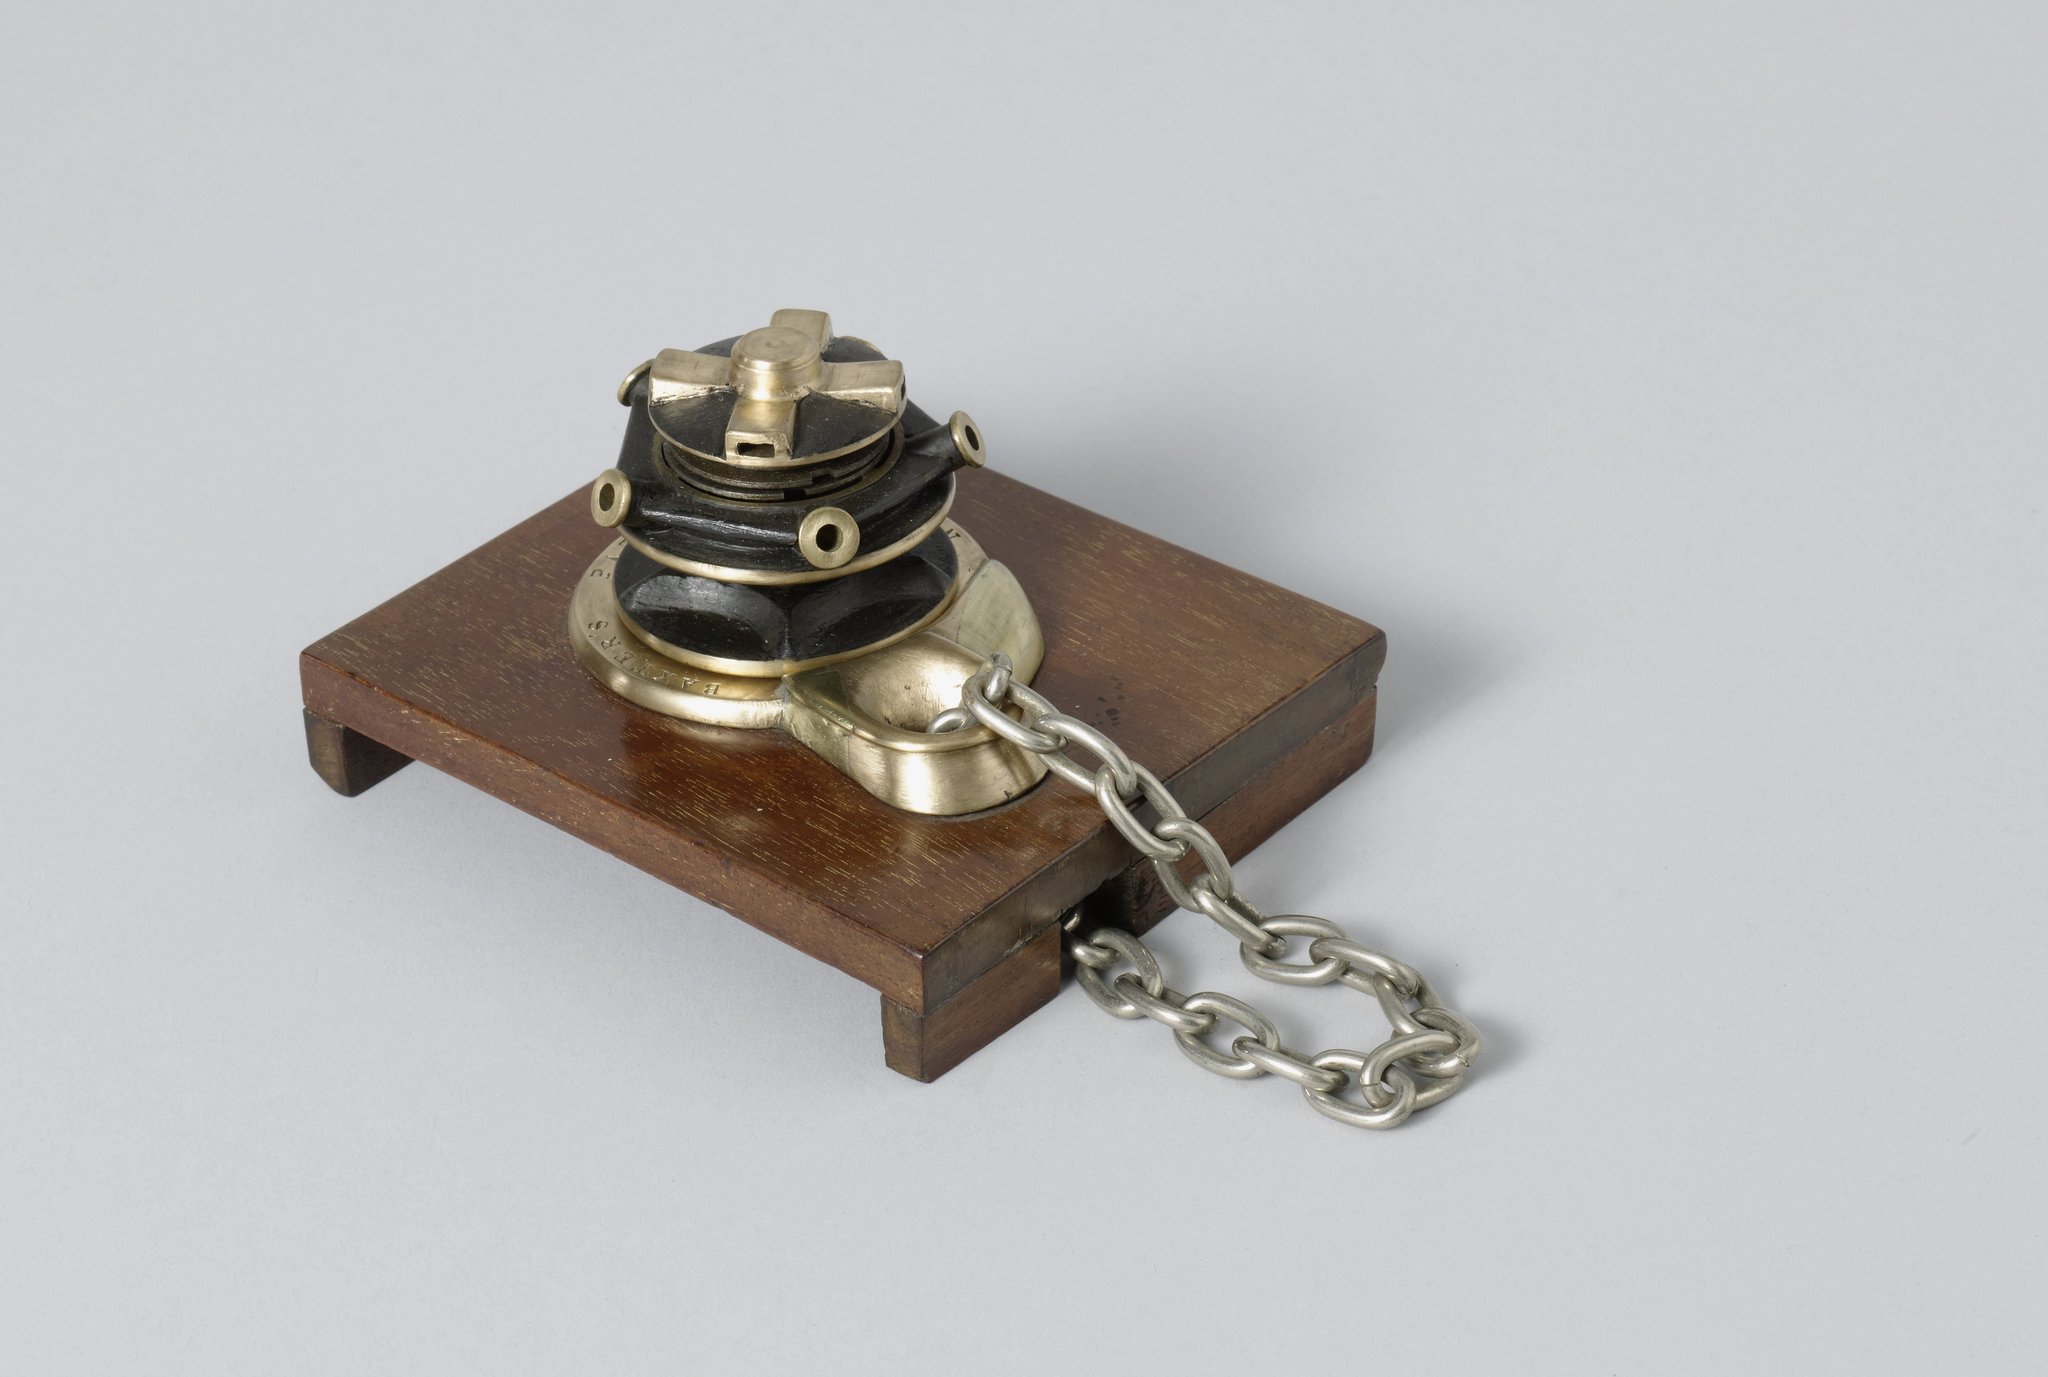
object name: demonstration model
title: Model of a Capstan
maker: samuel baxter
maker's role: engineer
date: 1870-1885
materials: bronze, iron, wood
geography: london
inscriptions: inscription, on the ring: ‘BAXTER's PATENT LONDON.’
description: Model van een kaapstander op een houten grondplankje, incompleet. De kaapstander ligt op een bronzen voetring met een kabelgat an een kant. De kaapstander heeft een Brown-Hartfield kabelhouderrand; de gaten voor vijf windbomen zijn direct boven deze rand aangebracht. De kop kan met vier platte windbomen neergeschroefd worden, waarmee de kaapstander geblokkeerd wordt. Het model is voorzien van een ketting zonder eind, die door het kabelgat en weer naar boven om de kaapstander heen loopt. Alle windbomen ontbreken.